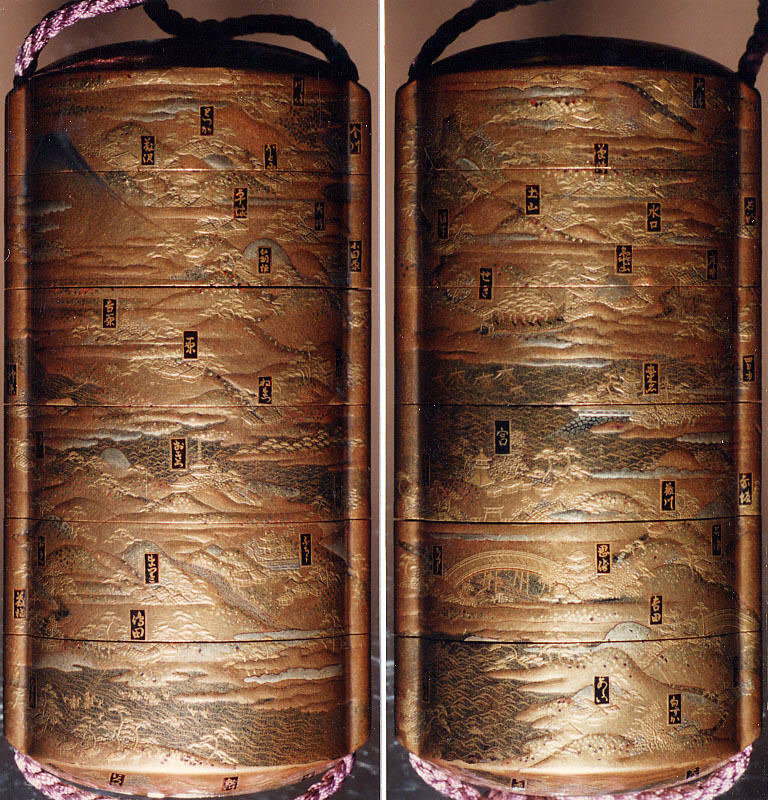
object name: inrō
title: Inrō with the “Fifty-three Stations of the Tōkaidō”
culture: japanese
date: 1801-1900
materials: gold, gold foil, silver, wood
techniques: carving, cutting, hiramakie, lacquer, relief, maki-e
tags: mountains,landscapes